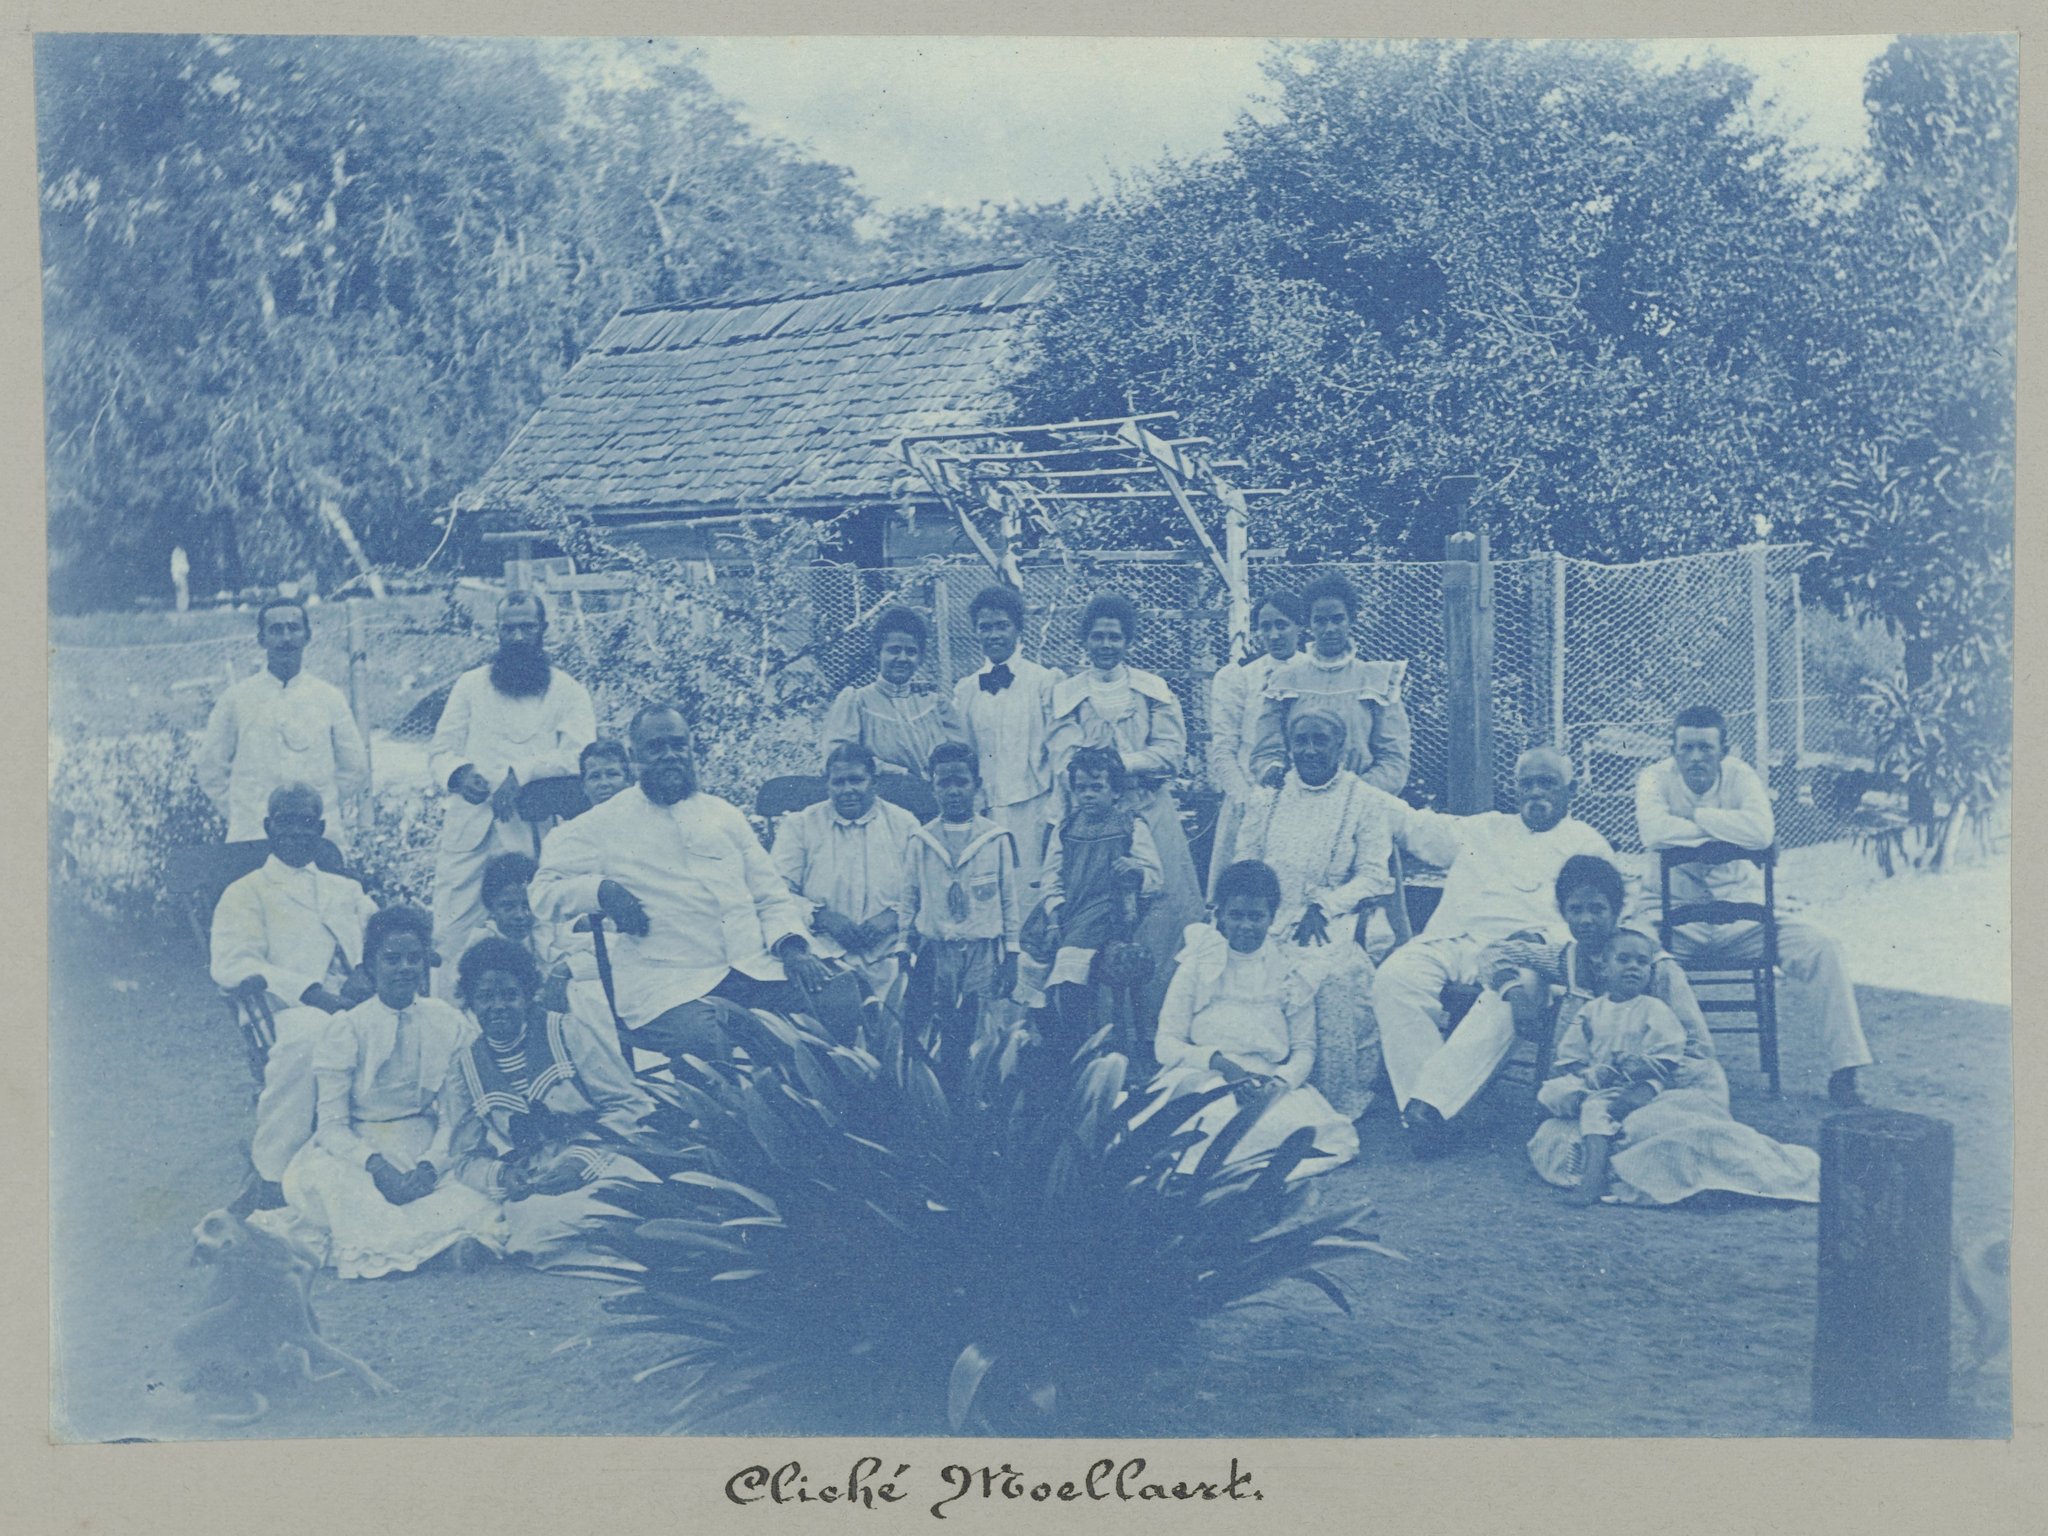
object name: photograph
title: Groepsportret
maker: moellaert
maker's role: fotograaf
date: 1906-1913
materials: photographic support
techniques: cyanotype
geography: suriname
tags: suriname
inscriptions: inscription: ‘E21 / Cliché Moellaert.’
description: Groepsfoto van een onbekende familie of groep. Onderdeel van het fotoalbum Souvenir de Voyage (deel 4), over het leven van de familie Dooyer in en rond de plantage Ma Retraite in Suriname in de jaren 1906-1913.